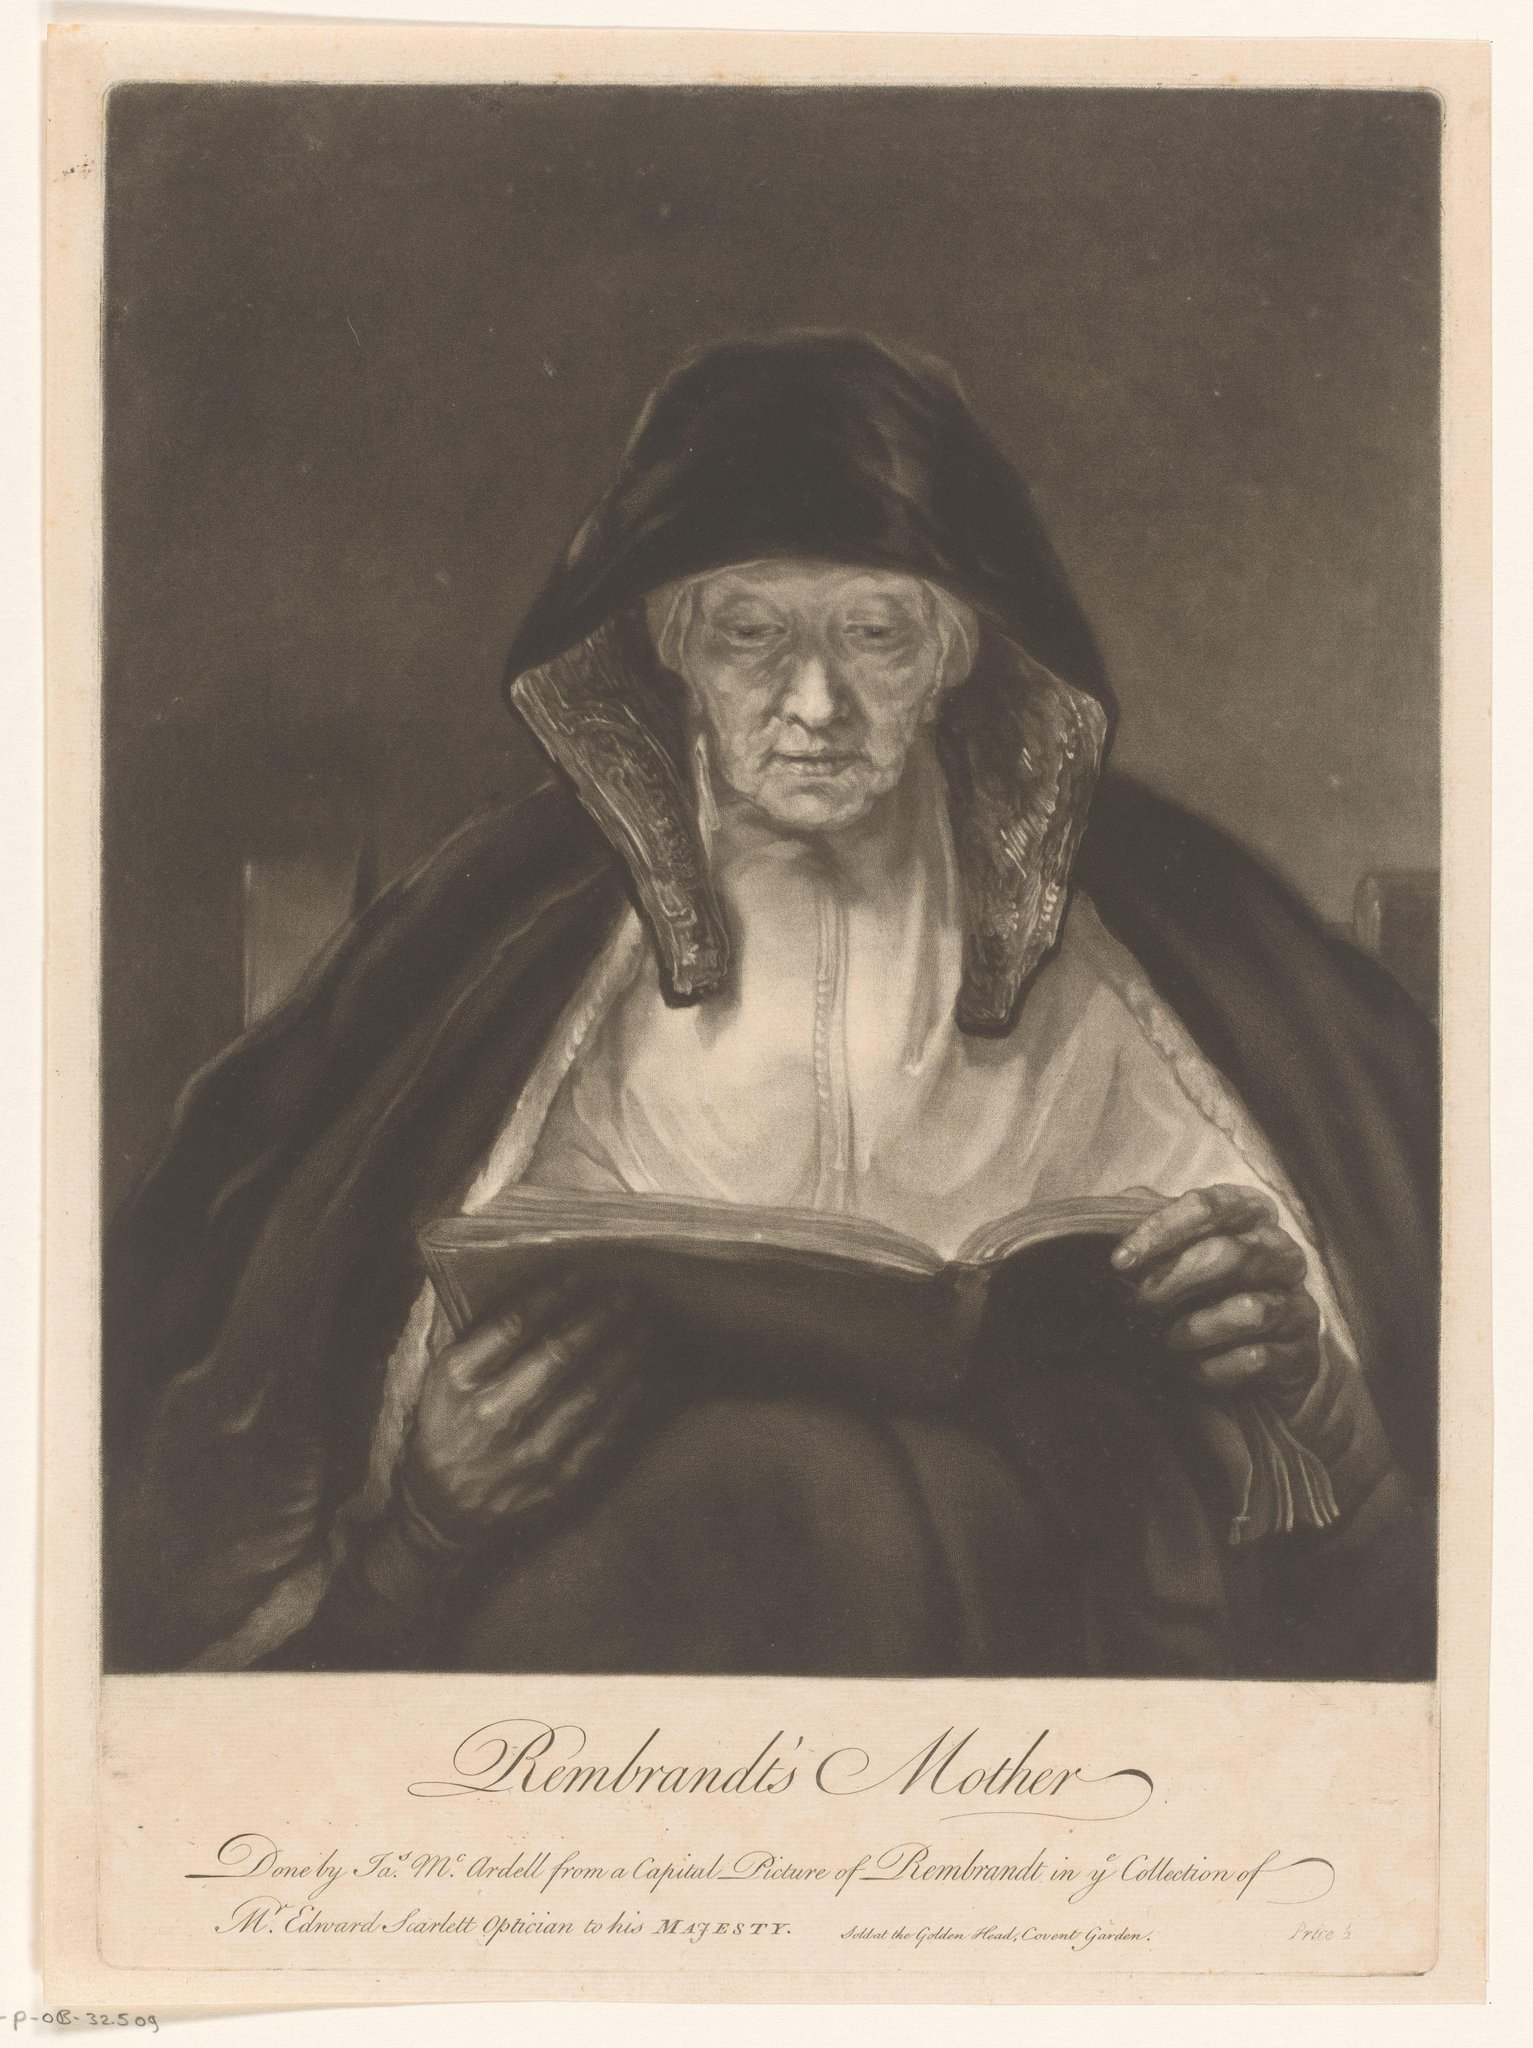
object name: print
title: Rembrandt's Mother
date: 1745-1765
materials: paper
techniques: mezzotint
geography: london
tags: reading, anonymous historical person portrayed - bb - woman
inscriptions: collector's mark: Lugt 240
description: Naar het schilderij van Rembrandt uit 1655 in de Buccleuch Collectie te Drumlanrig.